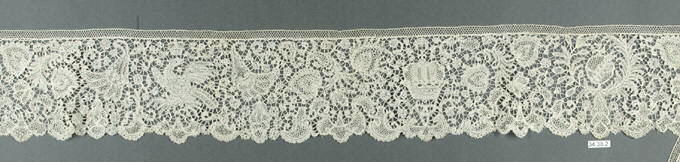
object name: border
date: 1701-1733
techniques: lace